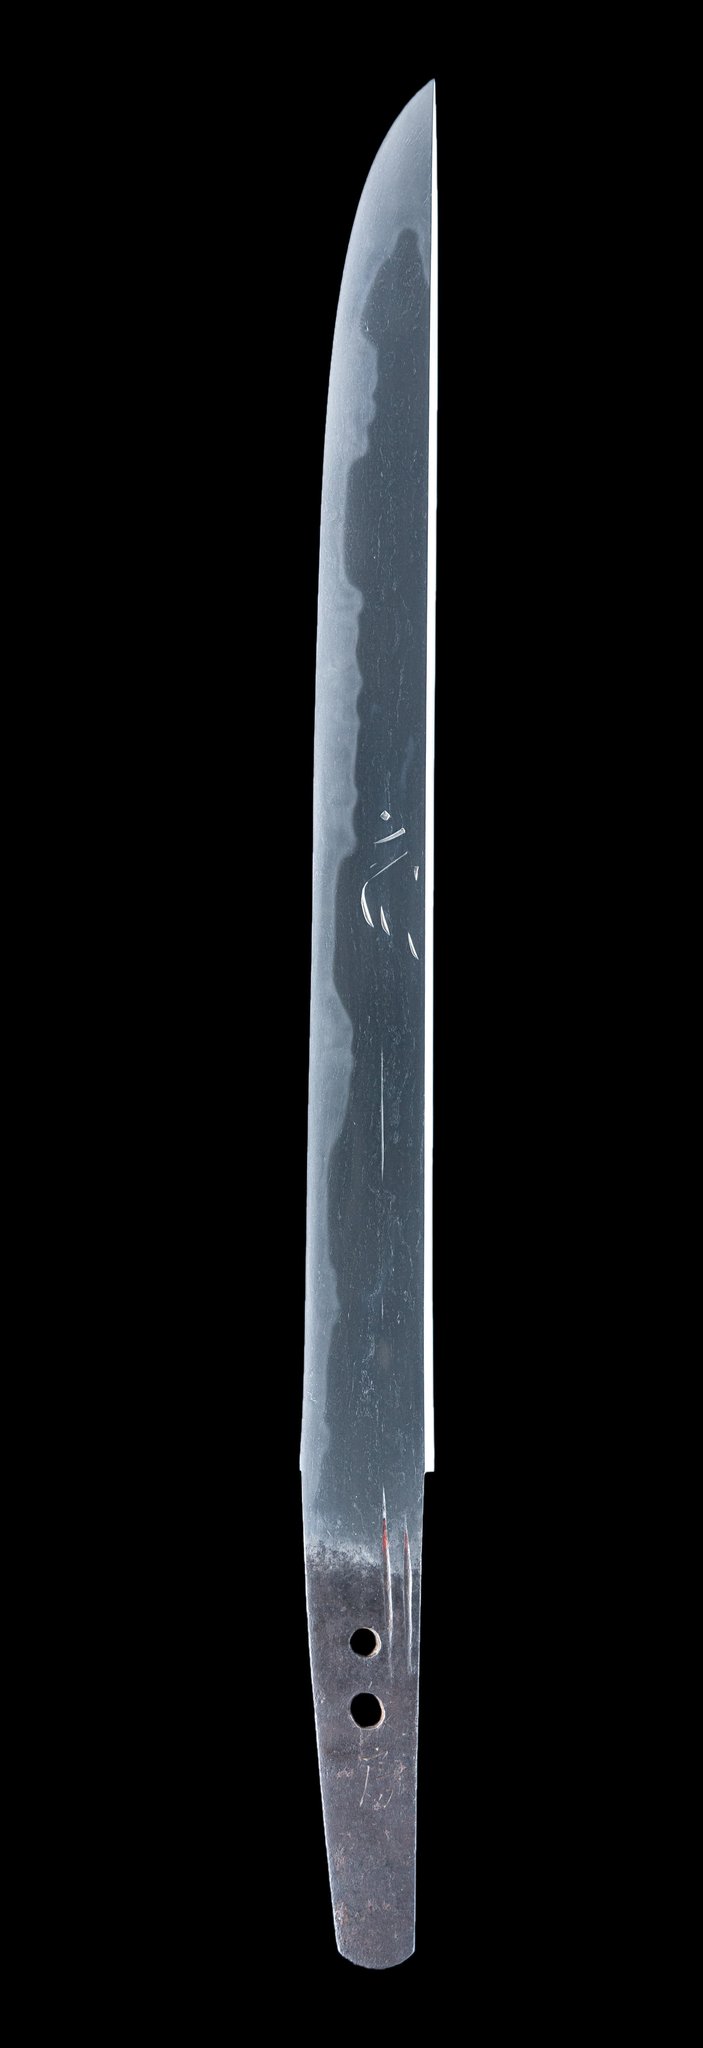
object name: blade and mounting for a dagger tantō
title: Blade and Mounting for a Dagger (Tantō)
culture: japanese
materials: gold alloy, gold, silver, steel, wood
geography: japan